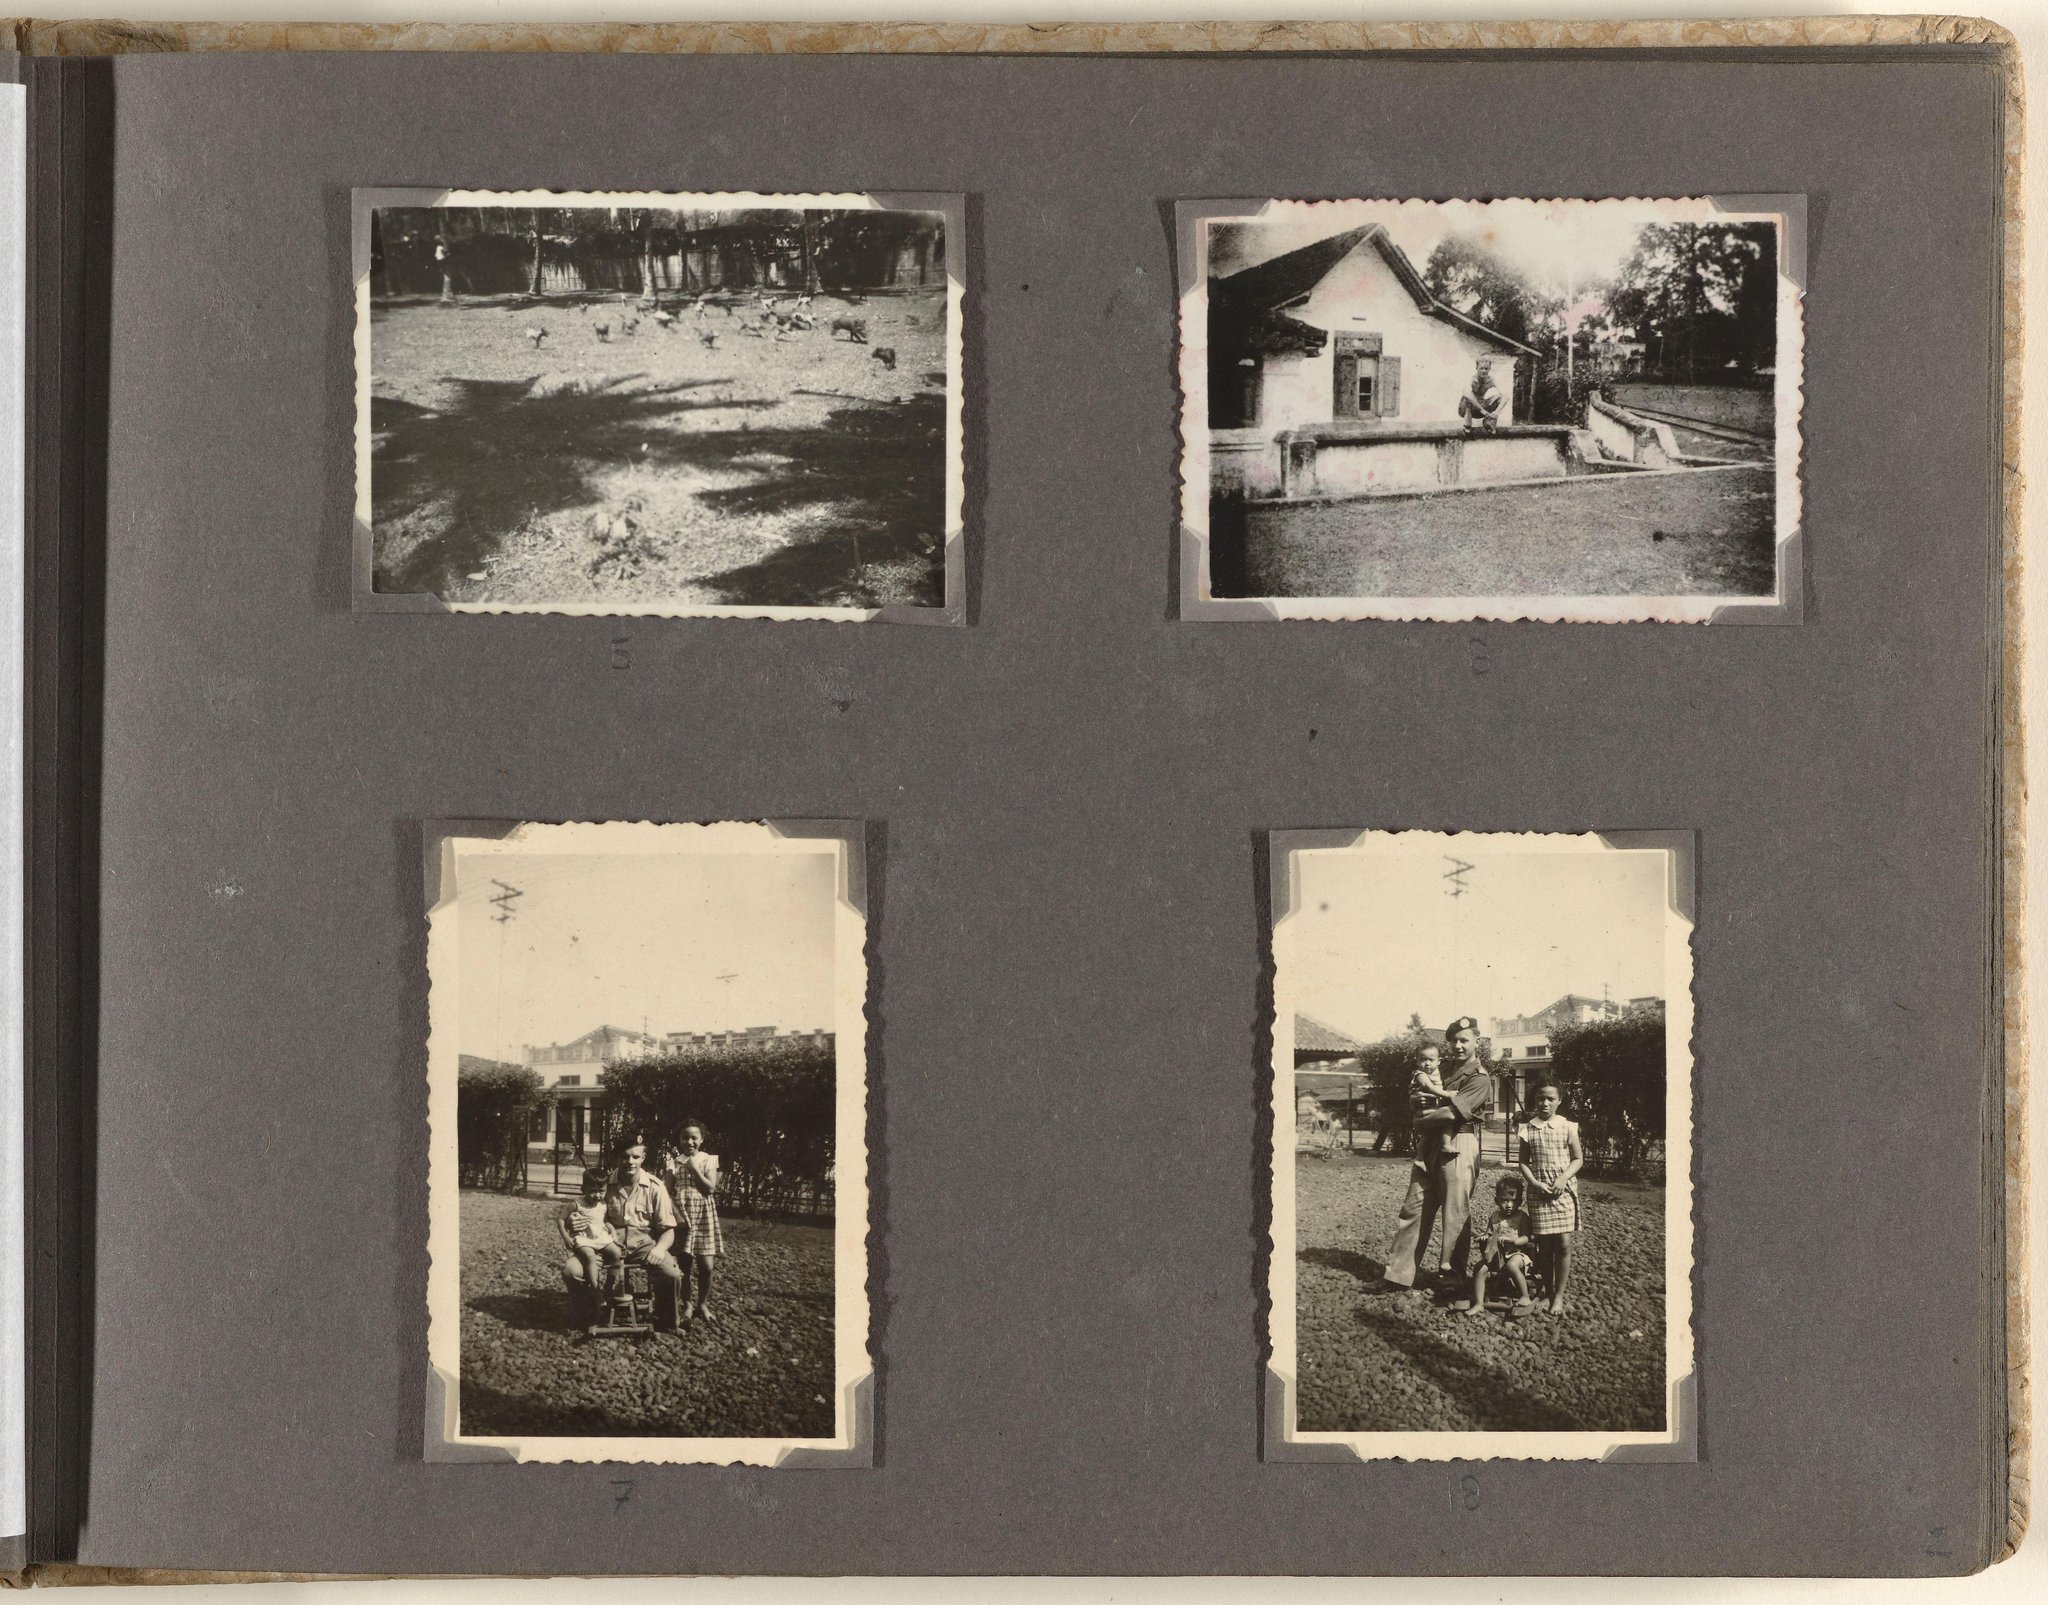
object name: album leaf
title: Diverse onderwerpen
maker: Anonymous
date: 1946-1949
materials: cardboard, photographic support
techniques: gelatin silver print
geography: dutch east indies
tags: colonial system, military service, dutch east indies, the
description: Albumblad met vier foto's: honden jagen op een varken, huis, Nederlandse militair met Indische kinderen. Onderdeel van het fotoalbum over de diensttijd van Nederlandse militairen in Indië, ca. 1946-1949.